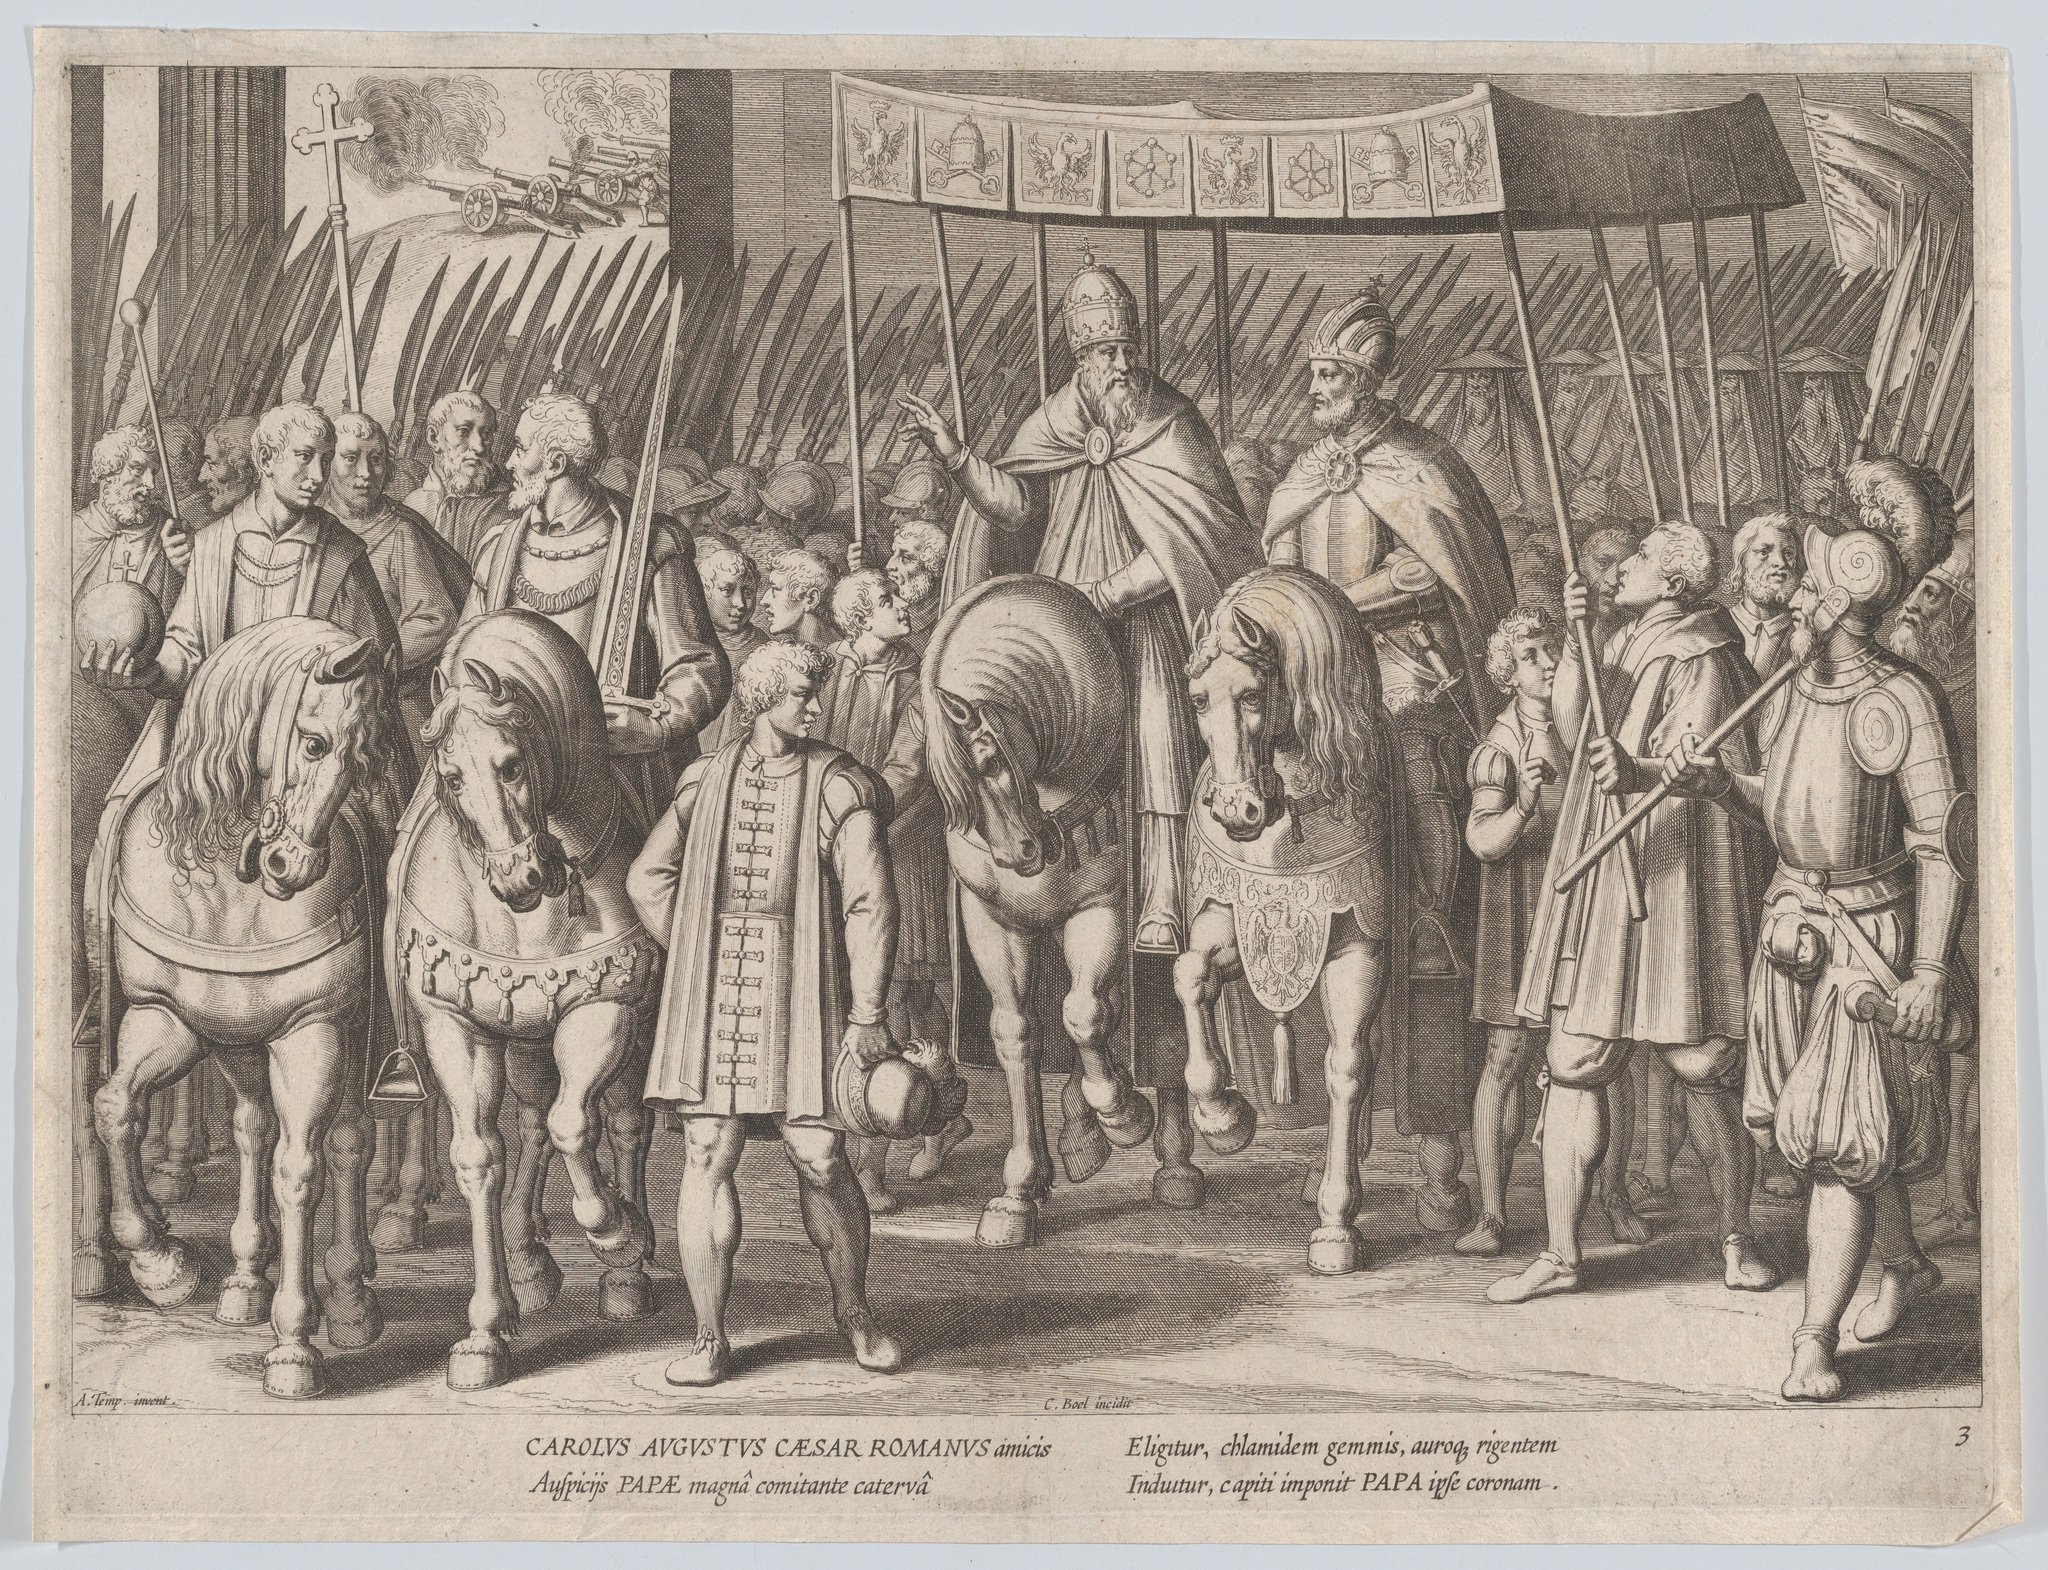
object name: print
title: Plate 3: Charles V Crowned Emperor entering Rome with the Pope, from the Triumphs of Charles V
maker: cornelis boel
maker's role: artist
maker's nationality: netherlandish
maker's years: 1576-1621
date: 1614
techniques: engraving, etching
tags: weapons,men,horses,popes